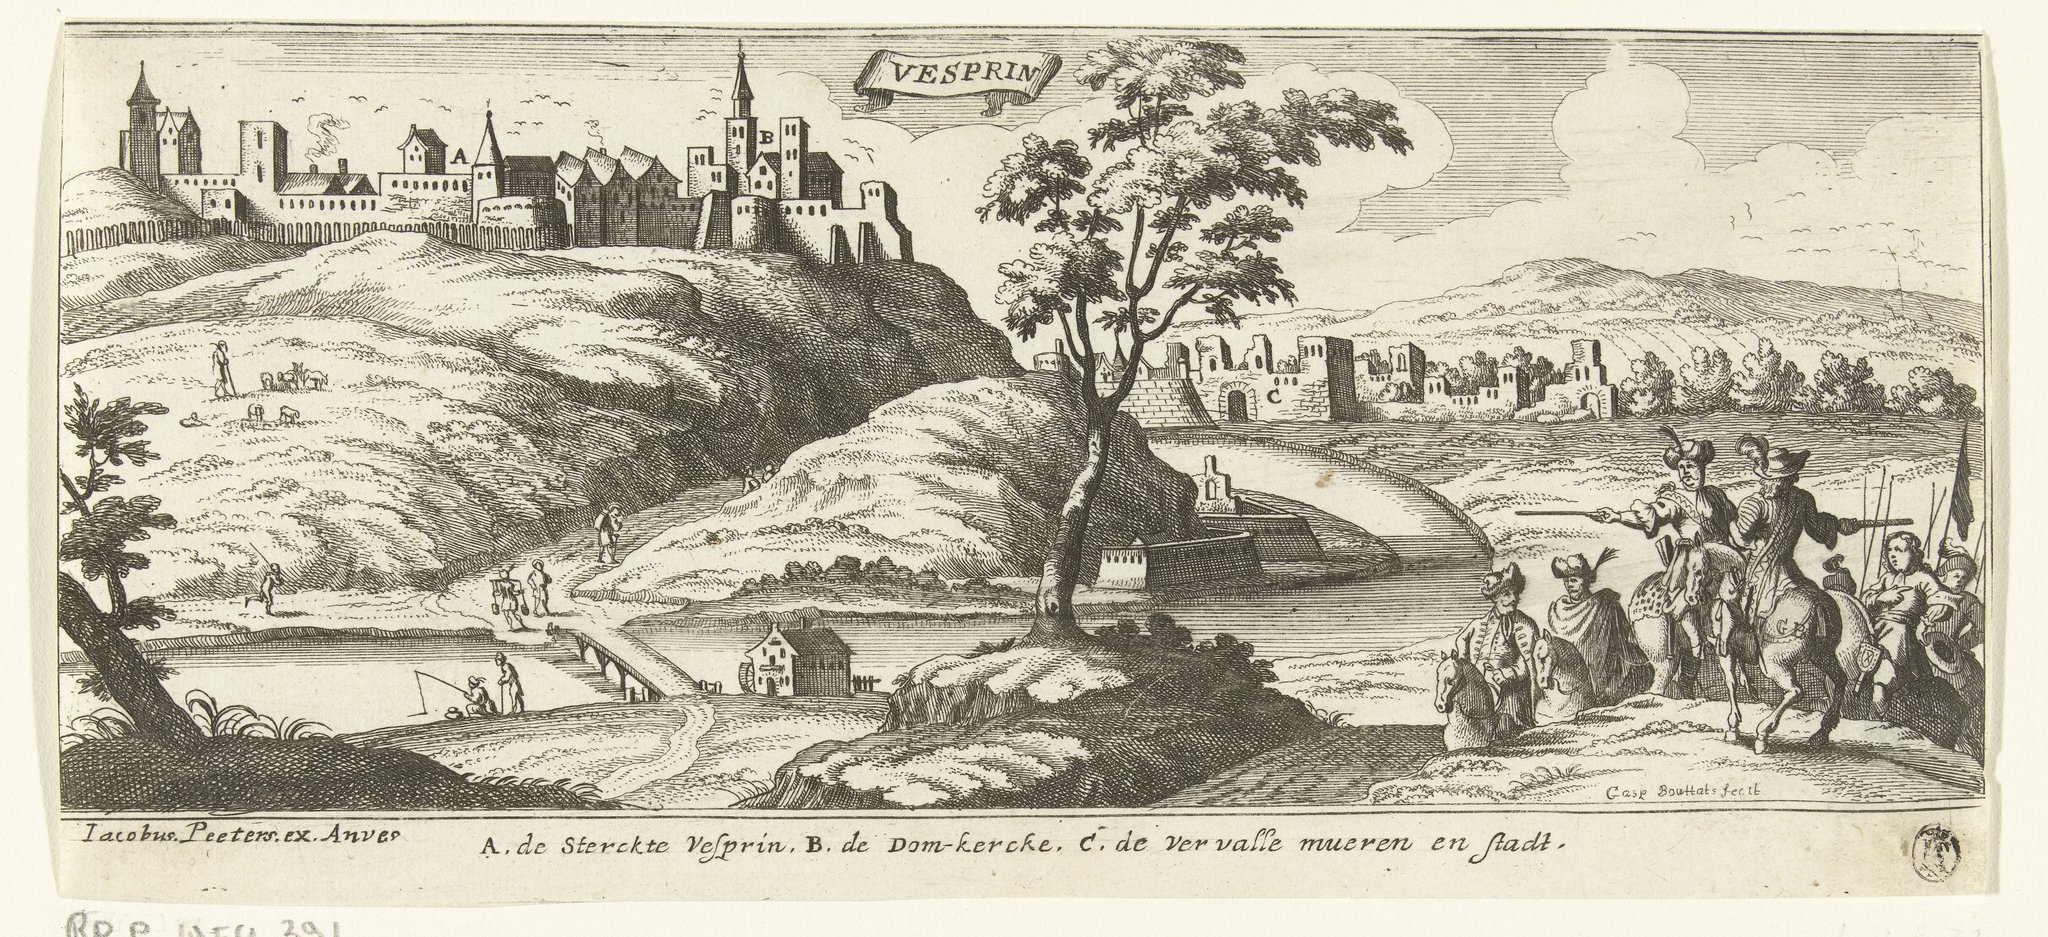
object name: print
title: Topografische afbeeldingen van Oostenrijk, Hongarije en de Balkan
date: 1686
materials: paper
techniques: etching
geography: antwerp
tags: prospect of city, town panorama, silhouette of city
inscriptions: collector's mark: Lugt 2760, collector's mark: Lugt 971, collector's mark: Lugt 2228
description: Gezicht op de stad Veszprém. De stad is gelegen op een heuvel. Op de voorgrond, buiten de stadsmuren, een rivier en een legereenheid te paard. Boven het stadsgezicht een cartouche met de naam van de stad. De prent heeft een Nederlands onderschrift met verwijzingen naar gebouwen op de prent.